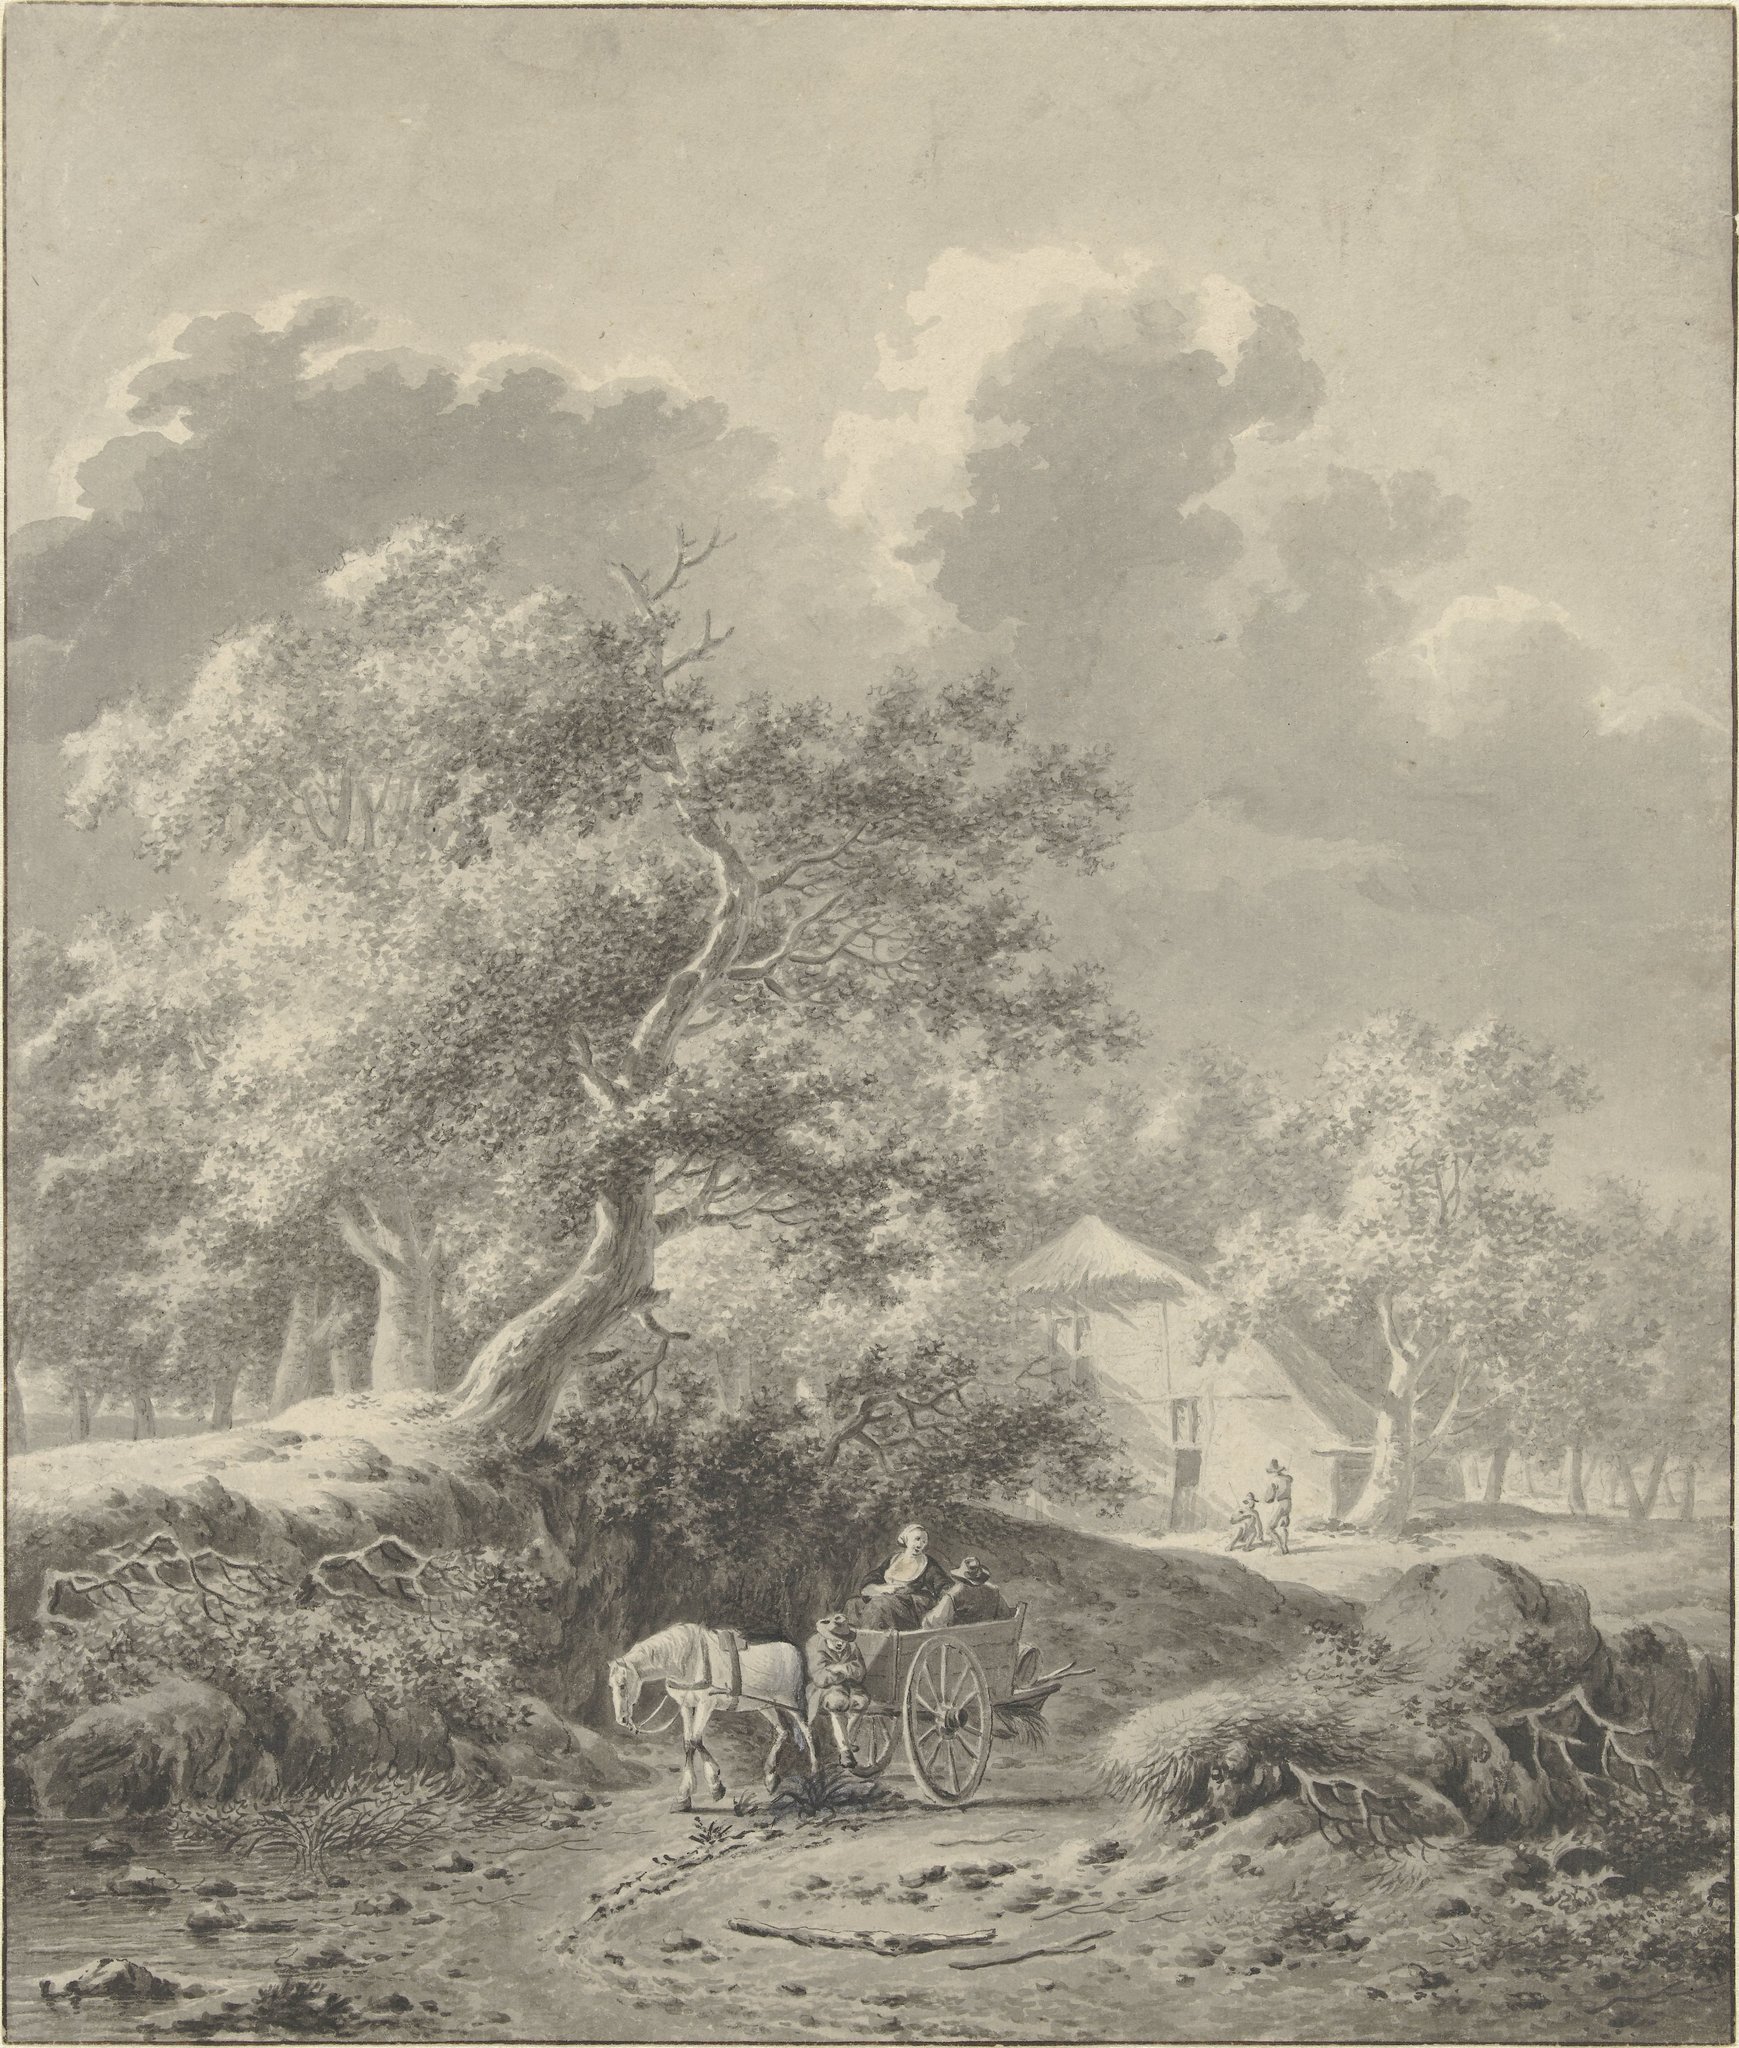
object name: drawing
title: Landschap met paard en wagen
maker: dirk jan van der laan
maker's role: draughtsman, painter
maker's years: 1759-1829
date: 1784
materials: chalk, ink, paper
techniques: brush, pen